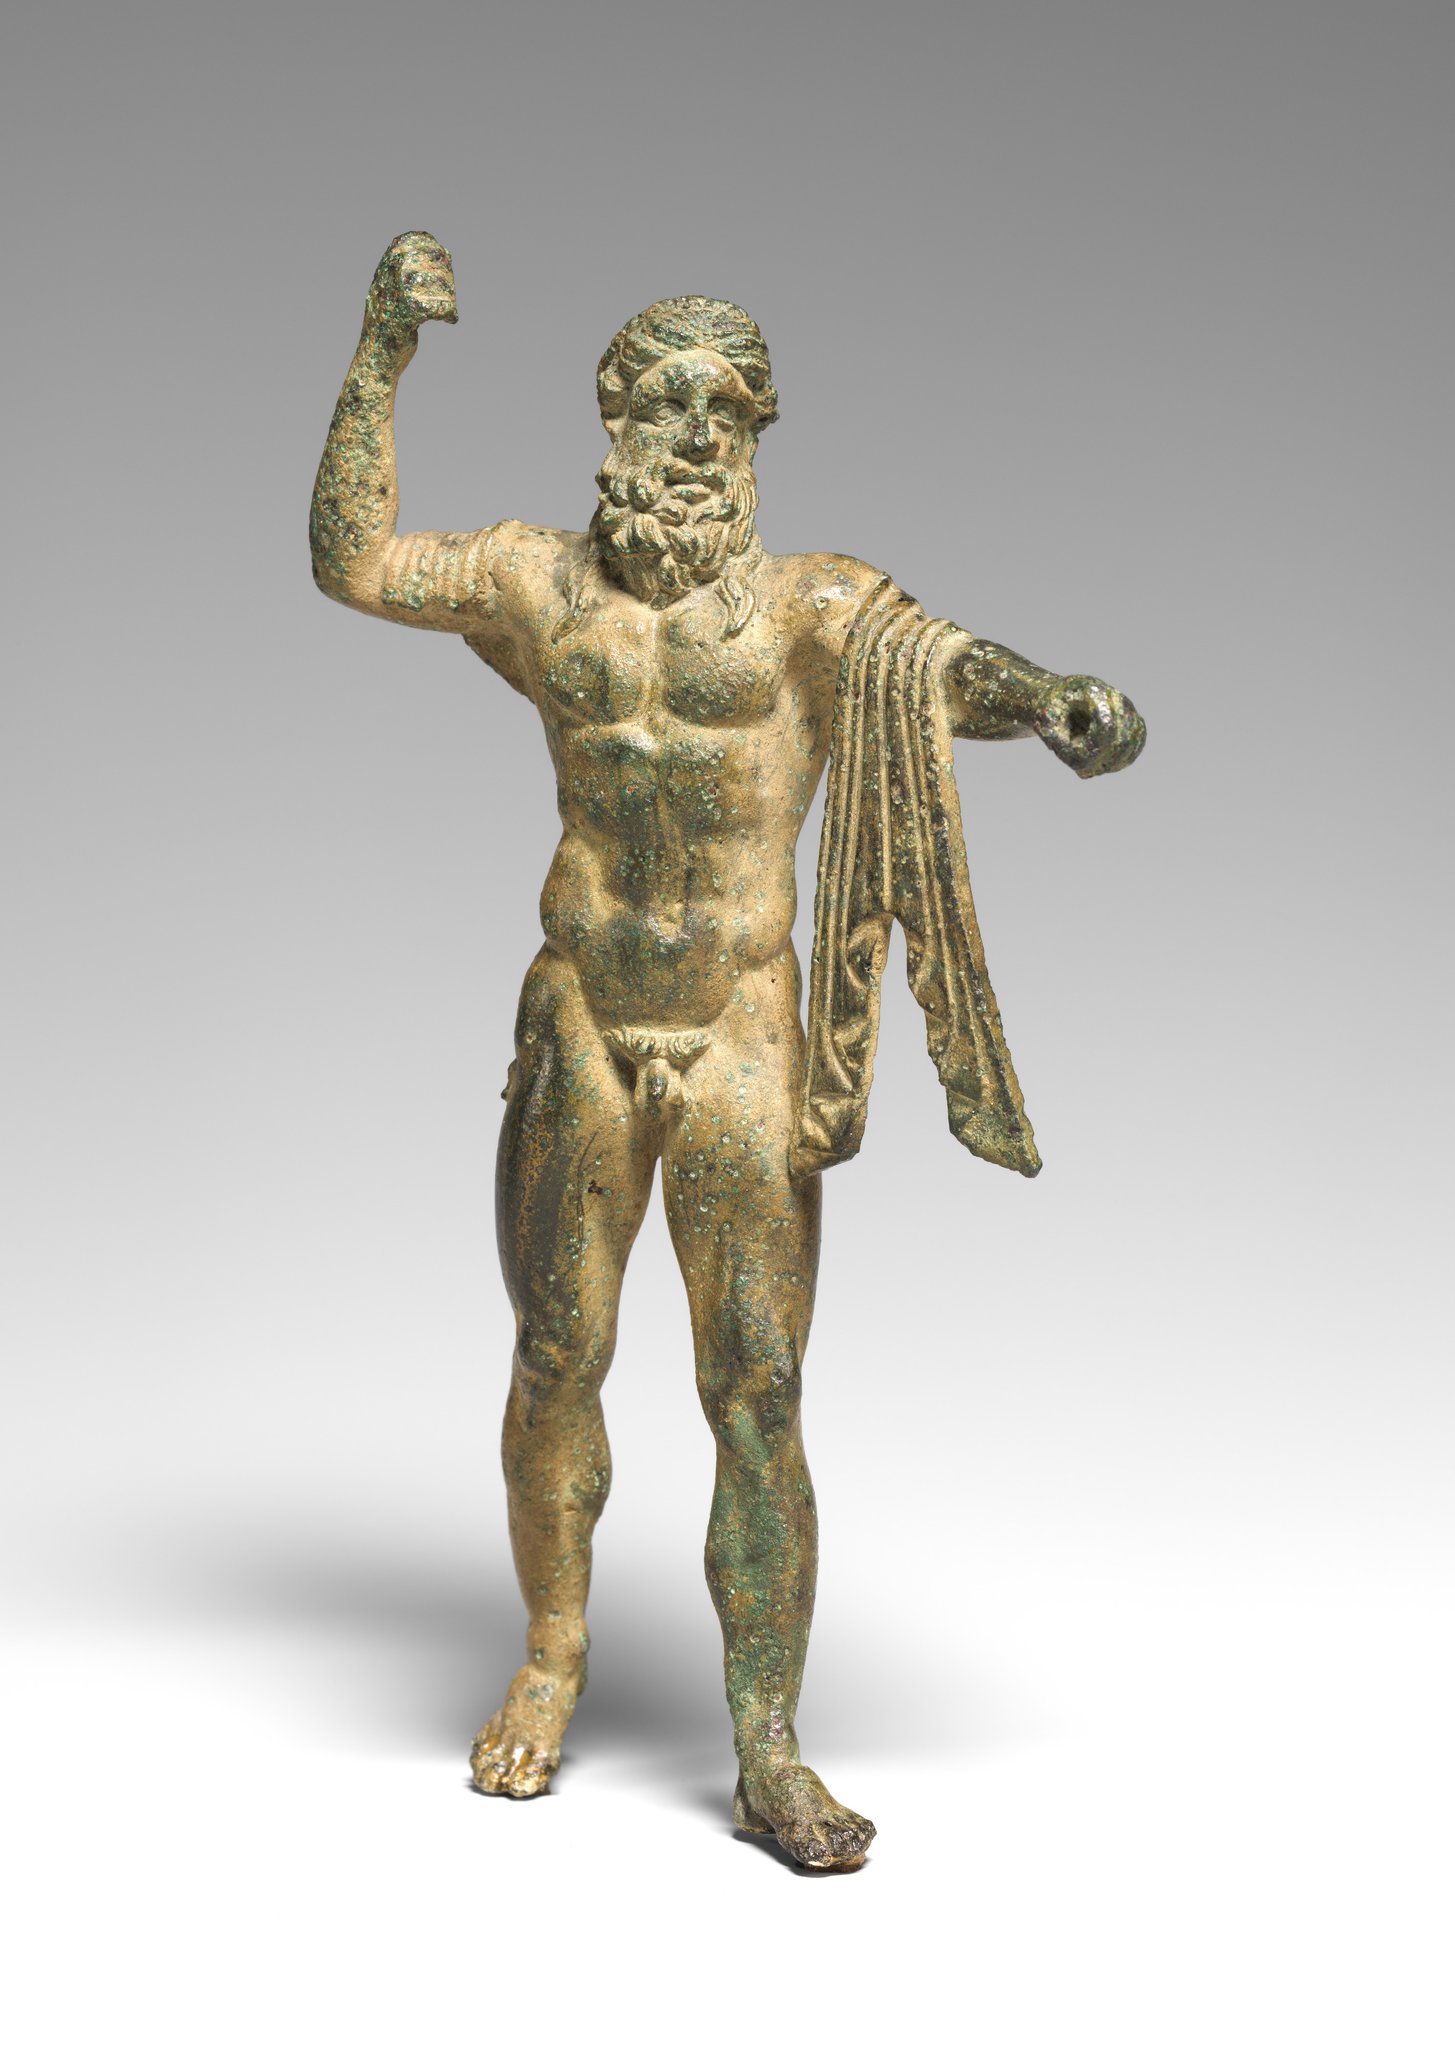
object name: statuette of poseidon, 4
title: Bronze statuette of Neptune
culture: roman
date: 1-33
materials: bronze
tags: neptune